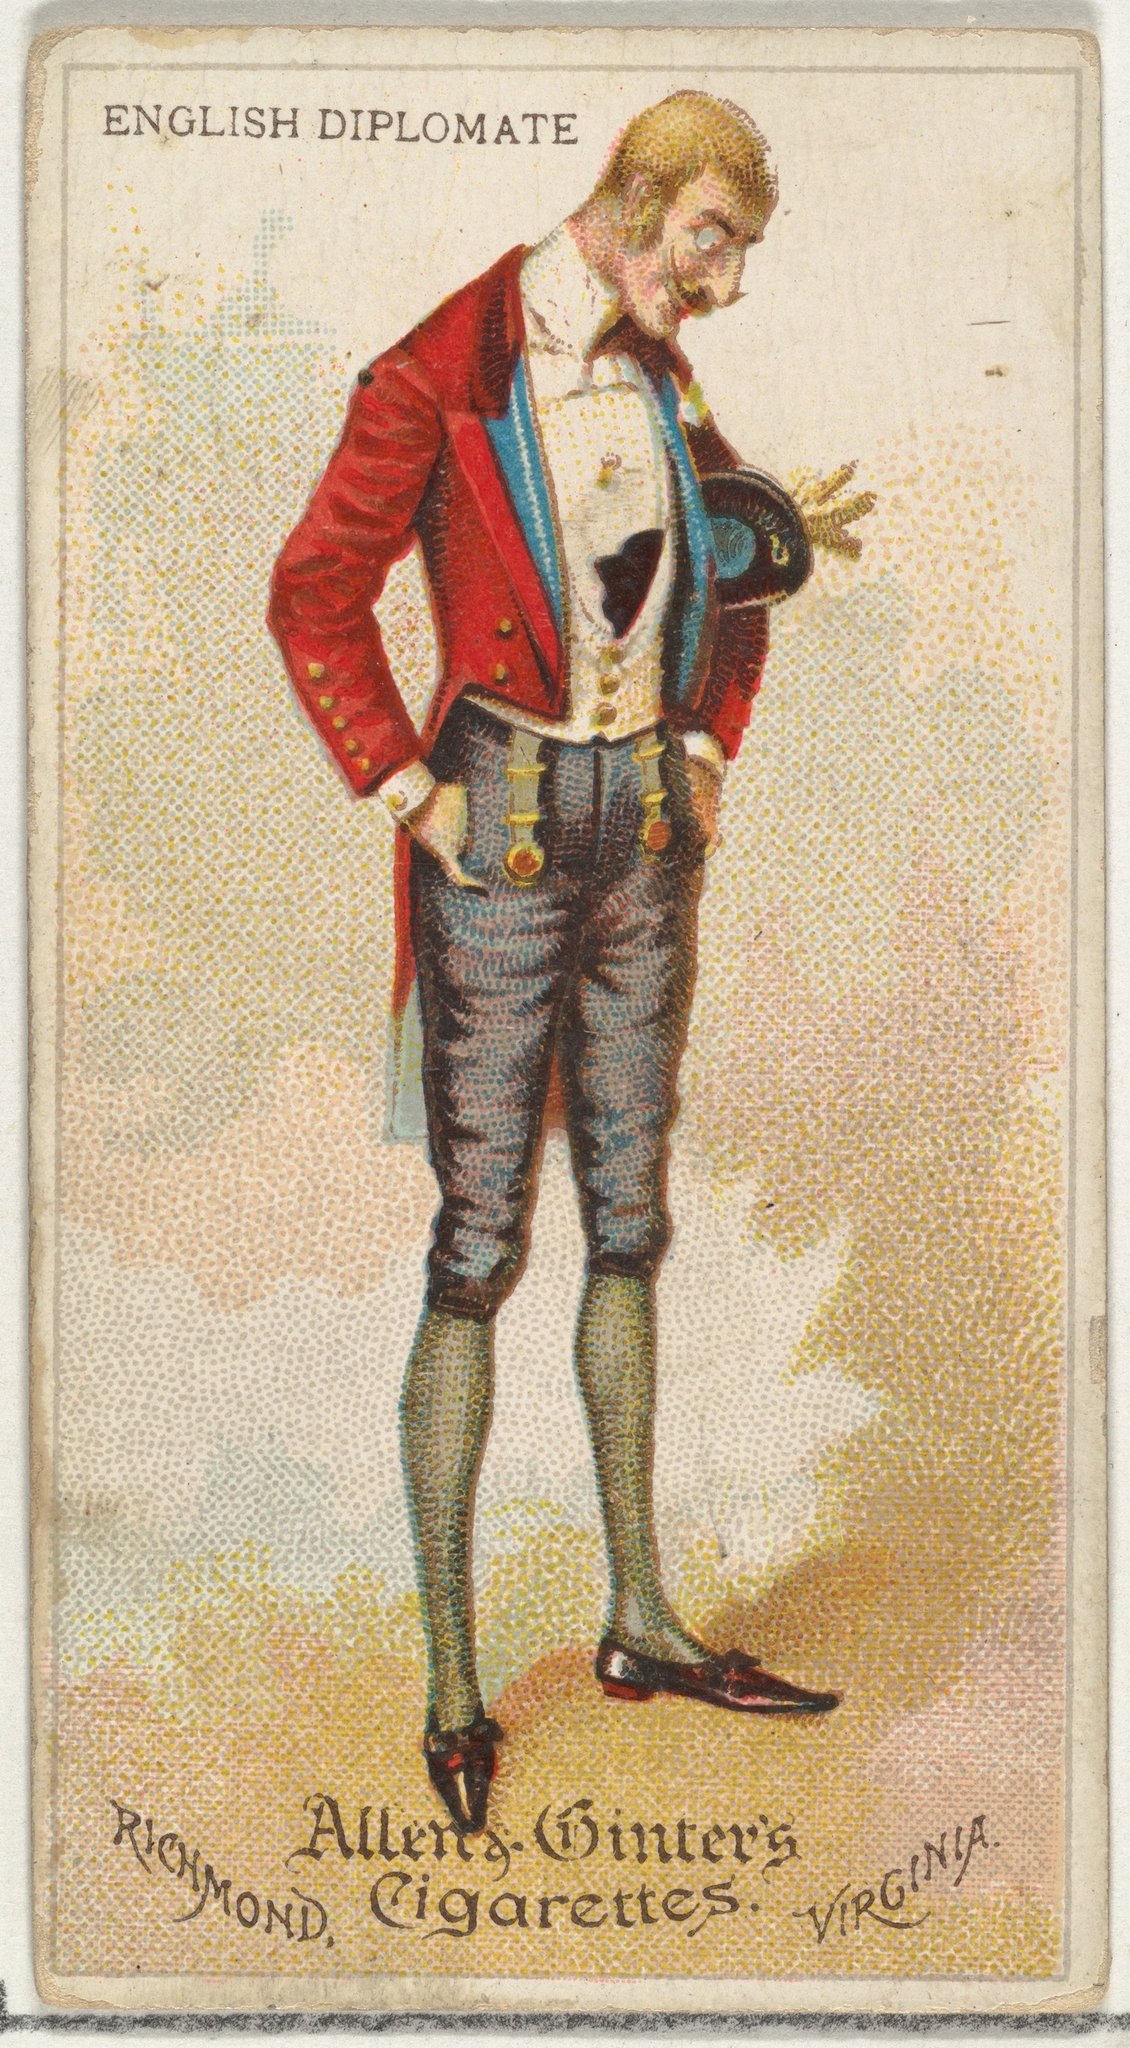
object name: print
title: English Diplomat, from World's Dudes series (N31) for Allen & Ginter Cigarettes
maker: allen & ginter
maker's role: publisher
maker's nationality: american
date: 1888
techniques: color lithograph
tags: men,profiles